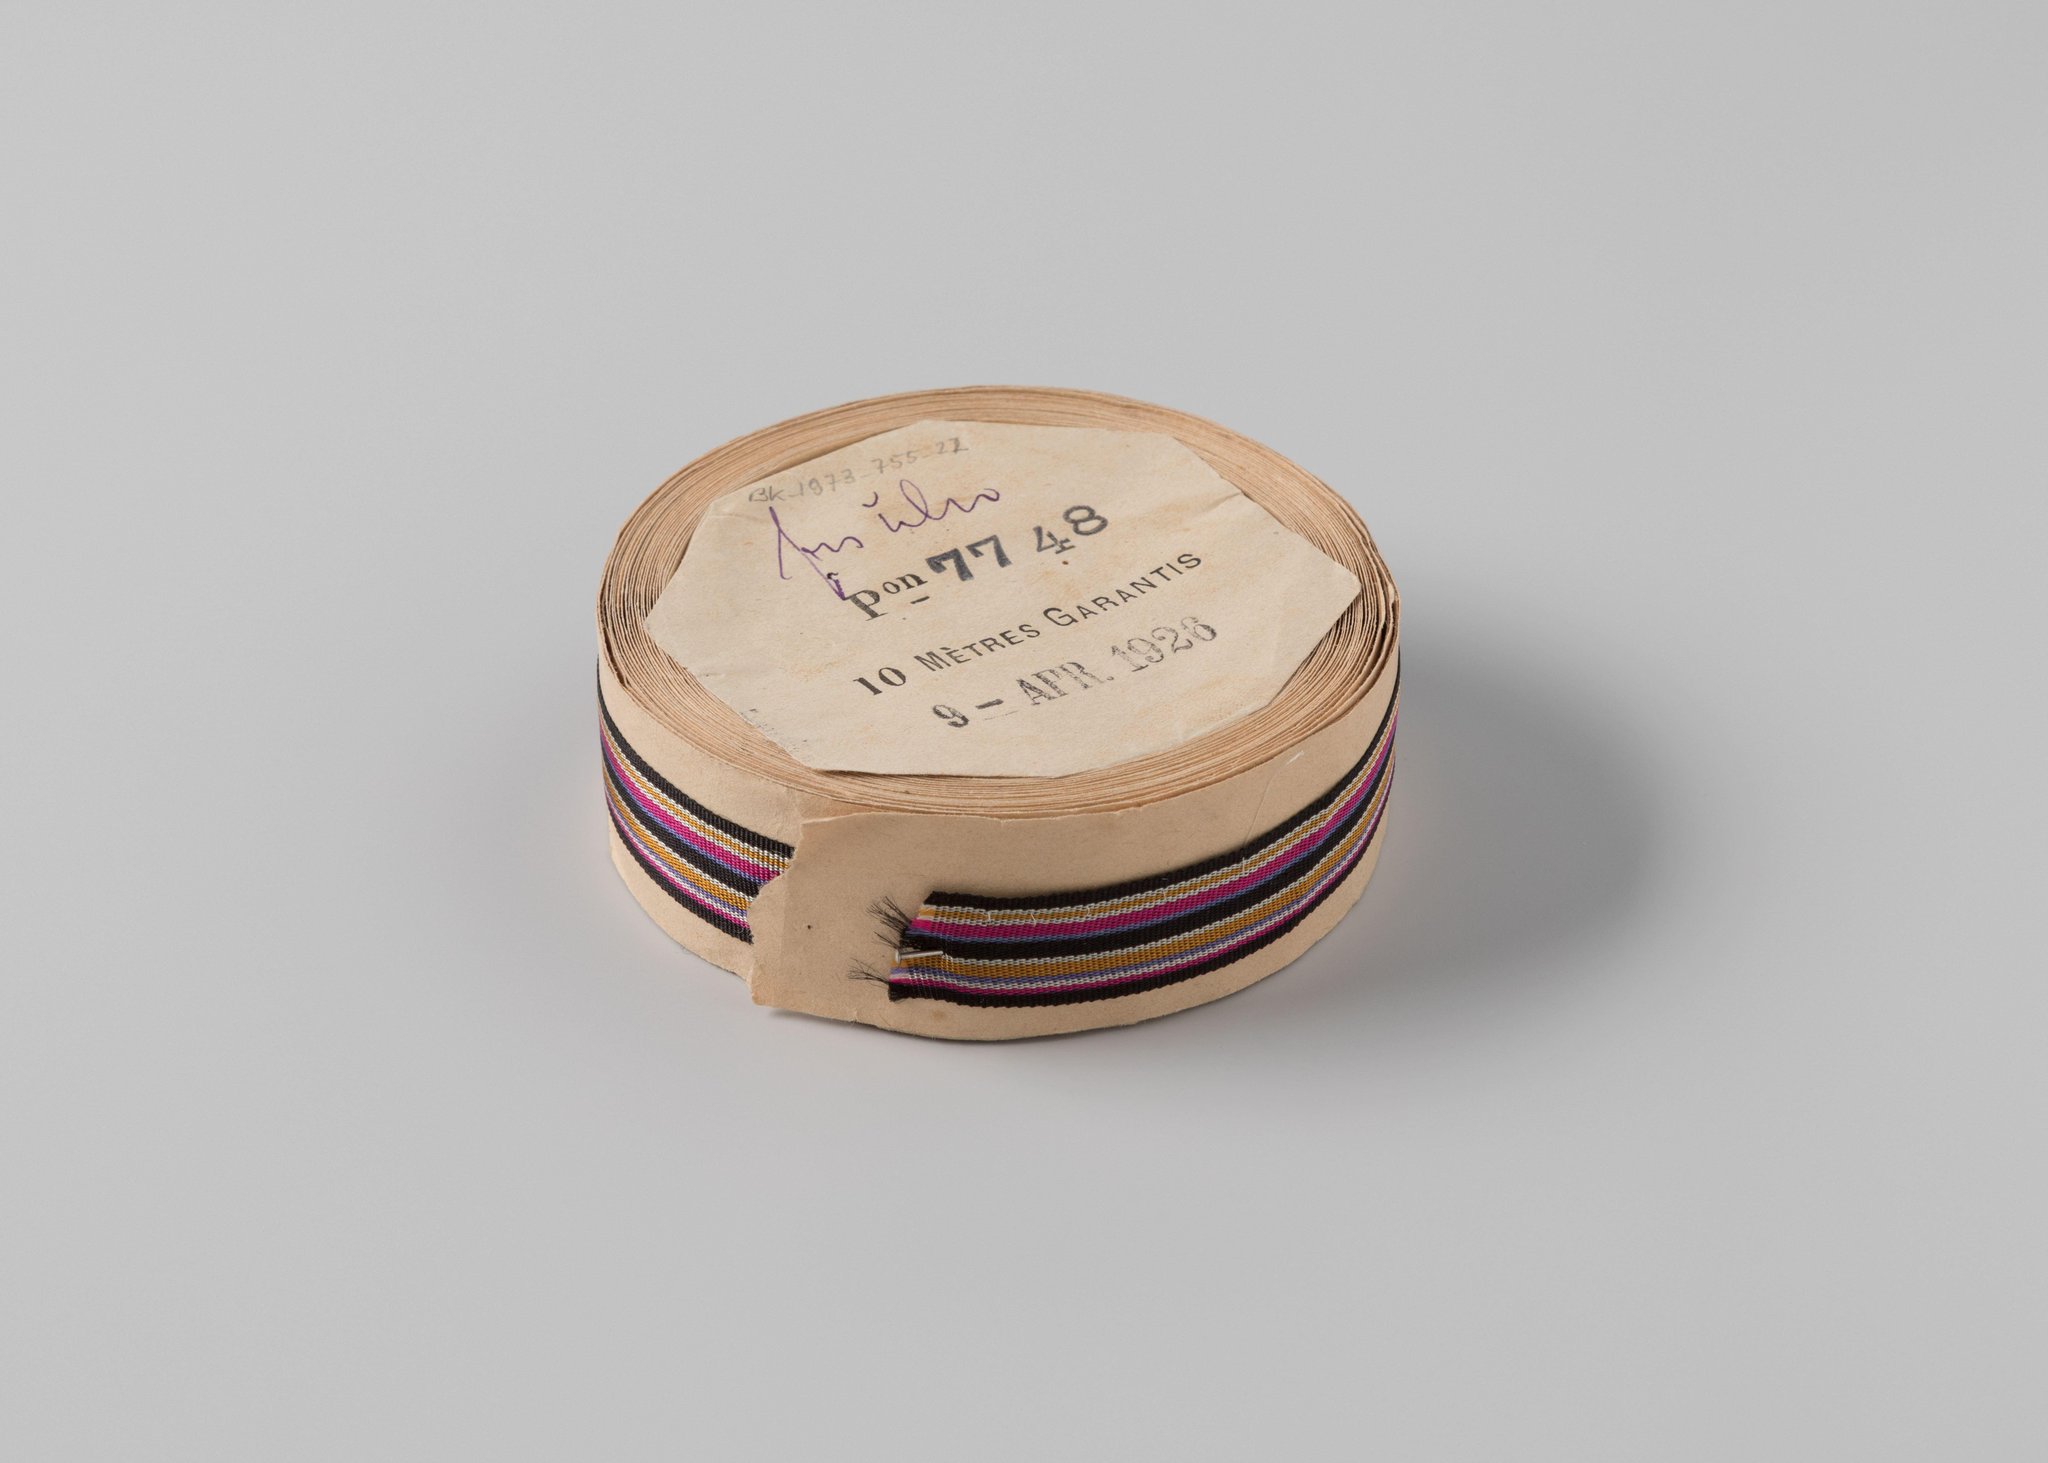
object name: ribbon material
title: Lint op rol, gestreept in zwart, lichtblauw, oker, fuchsia en lila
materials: cardboard, paper, textile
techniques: weave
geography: france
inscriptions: number: ‘Pon 7748’, stamp: ‘9 - APR. 1926’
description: Lint op rol, gestreept in zwart, lichtblauw, oker, fuchsia en lila.